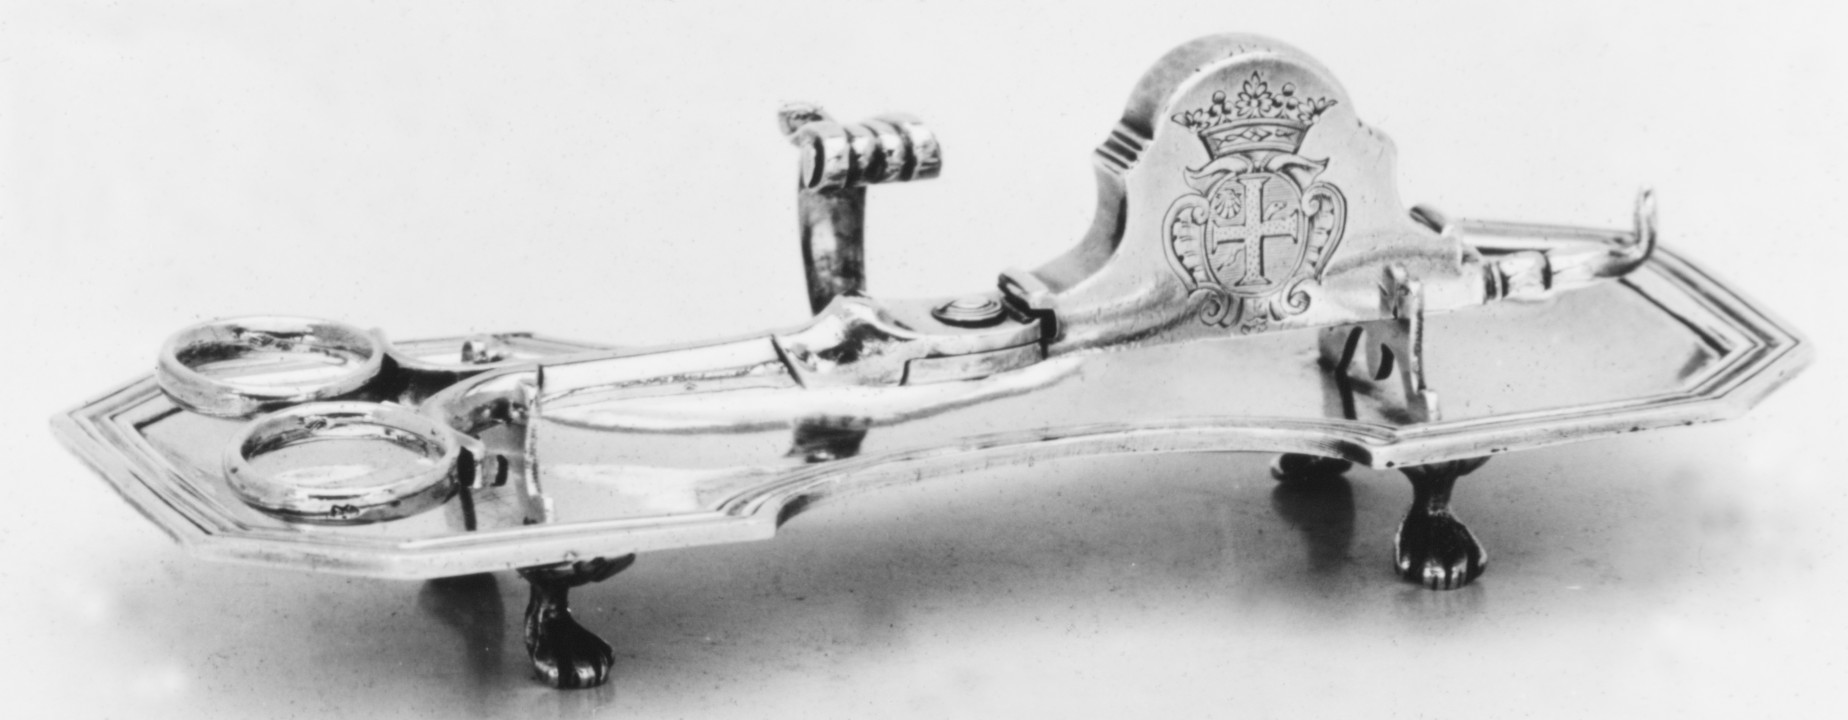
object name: snuffer tray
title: Snuffers and tray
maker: achille bellanger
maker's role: maker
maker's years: 1673-1745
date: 1718-1719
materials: silver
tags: coat of arms